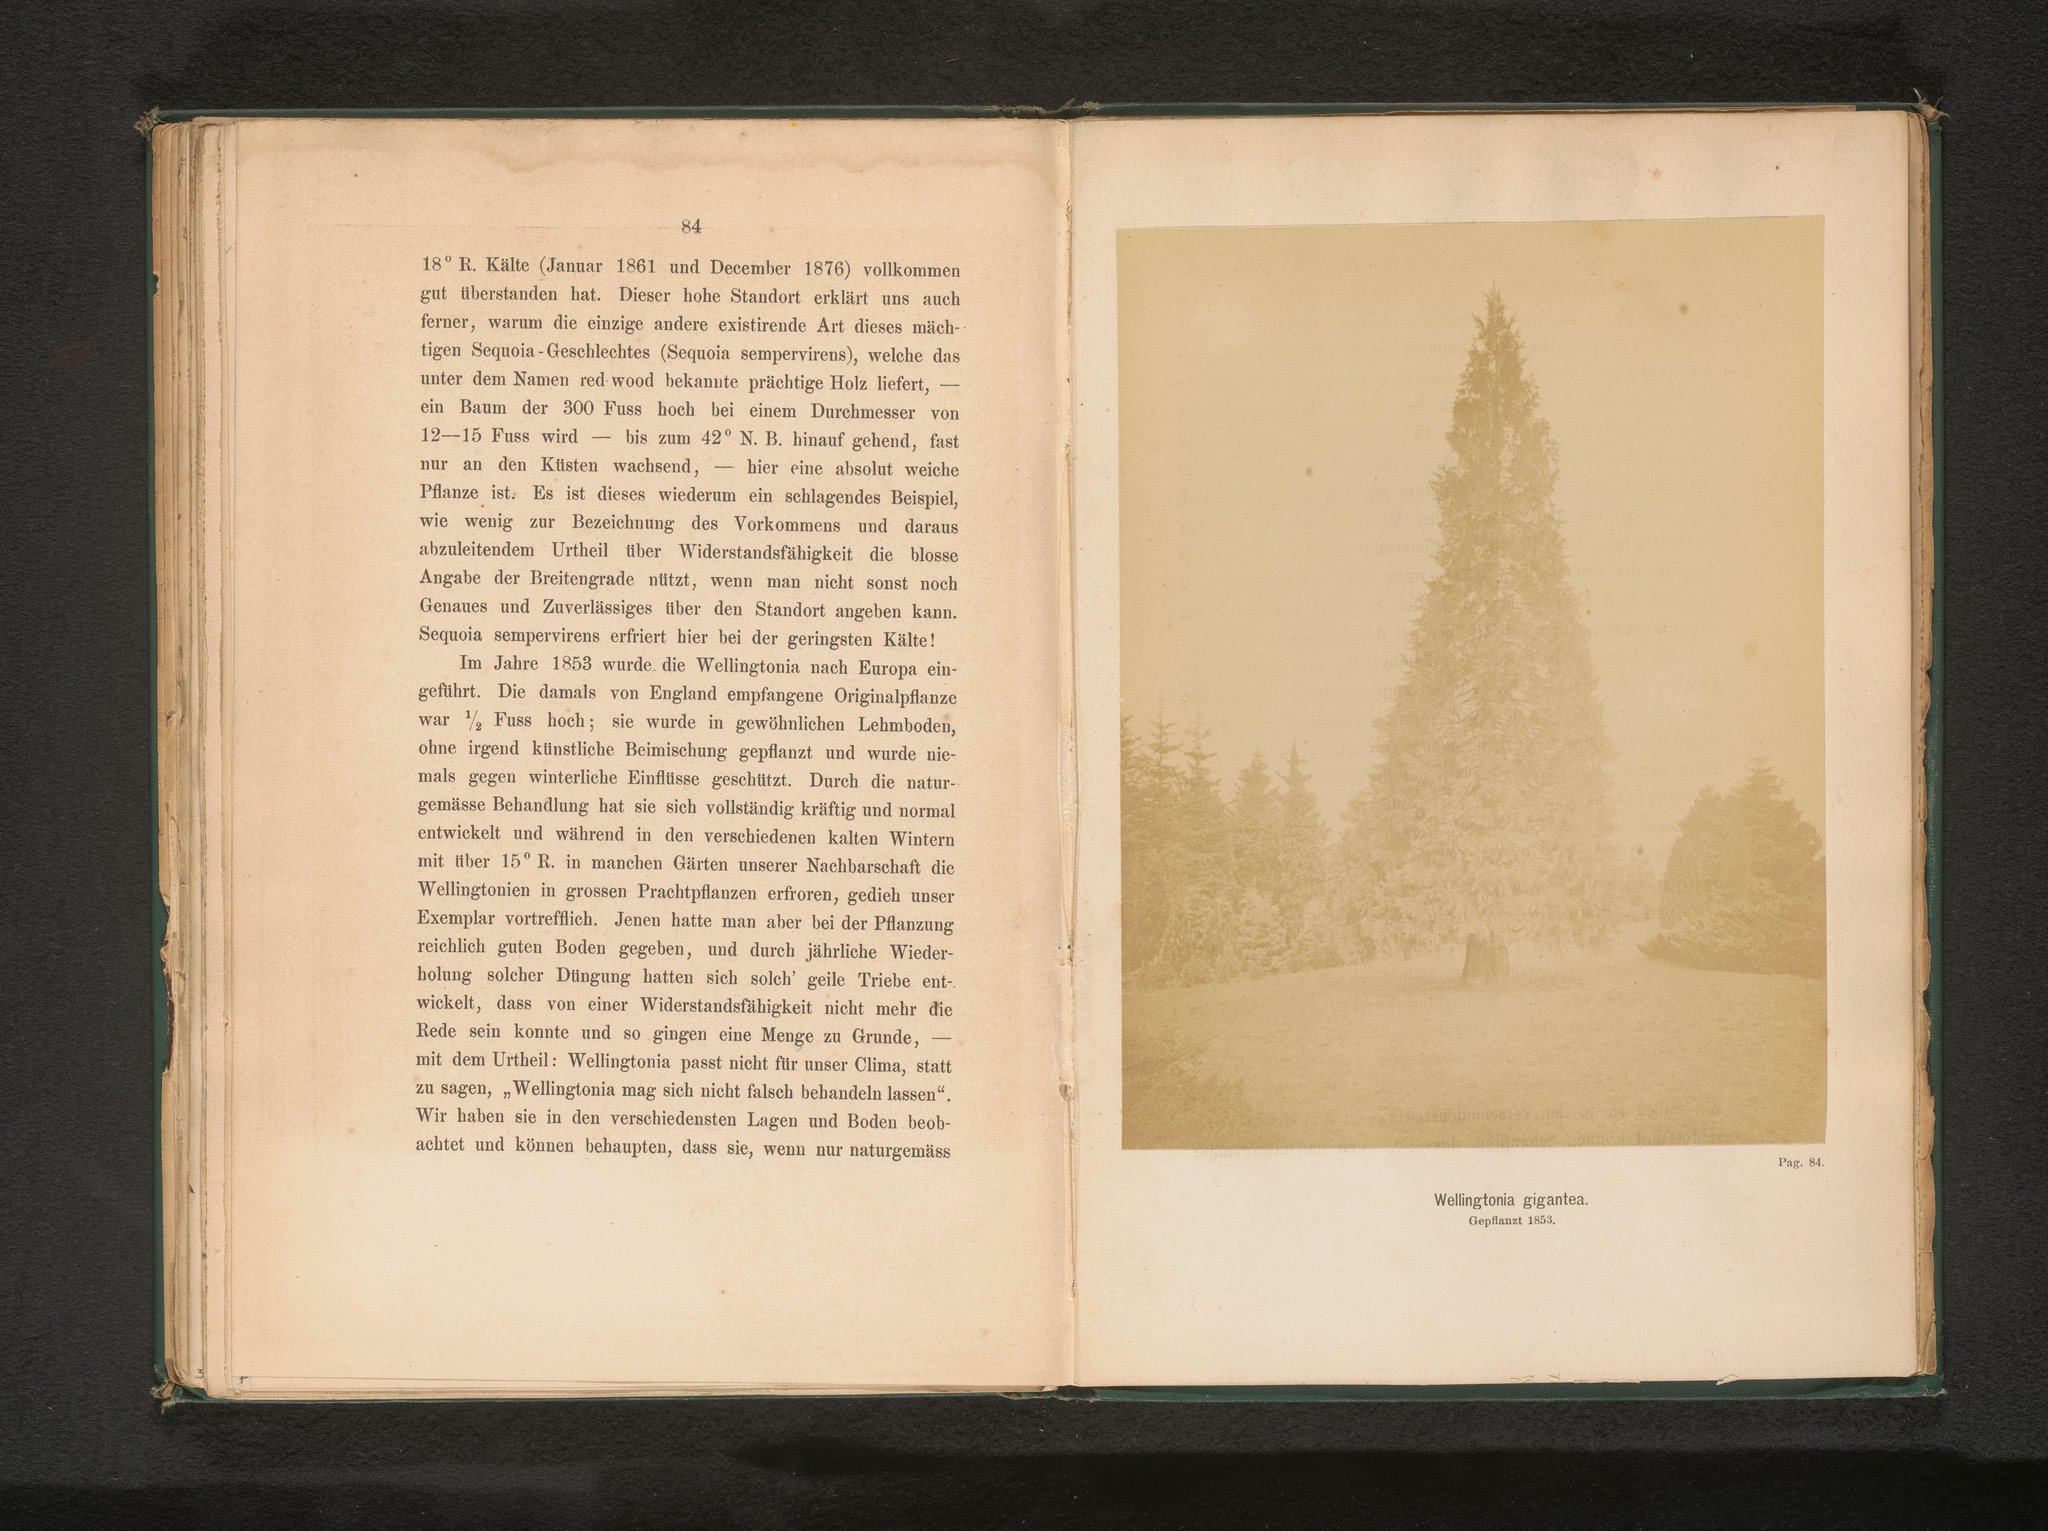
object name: page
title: Reuzensequoia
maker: Anonymous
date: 1867-1877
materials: photographic support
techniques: albumen print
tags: trees: cypress